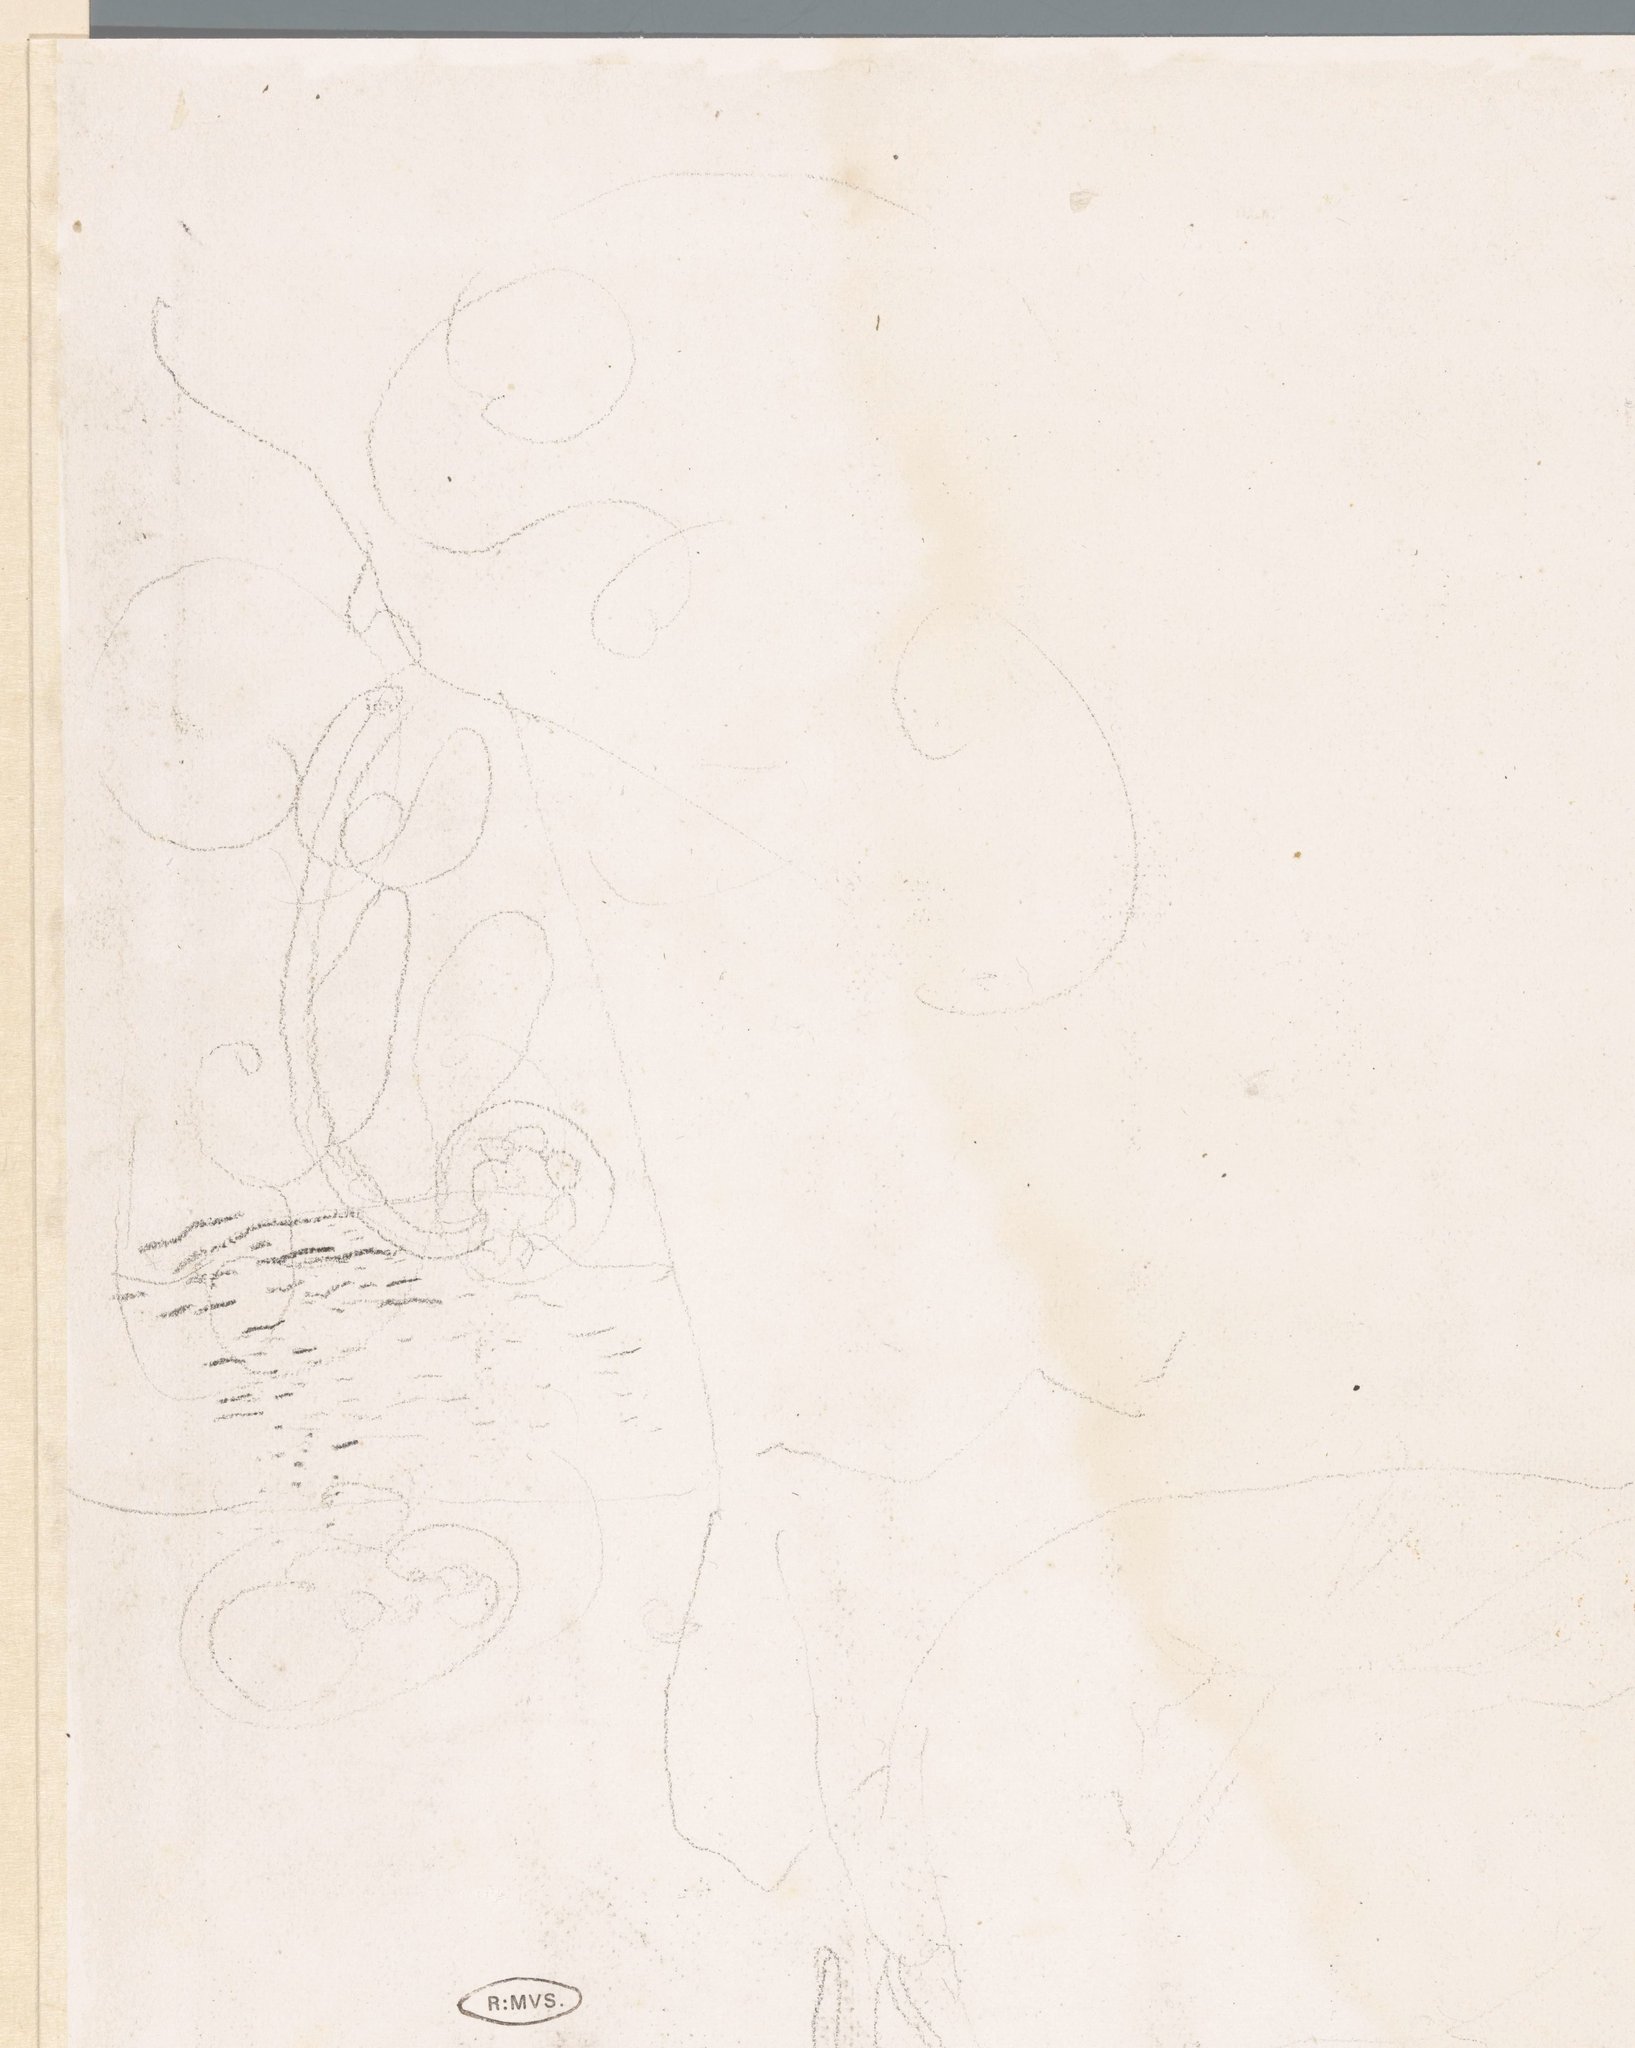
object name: drawing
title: Kind met pauw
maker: richard nicolaüs roland holst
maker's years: 1868-1938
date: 1892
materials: chalk, paper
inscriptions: collector's mark: Lugt 2228